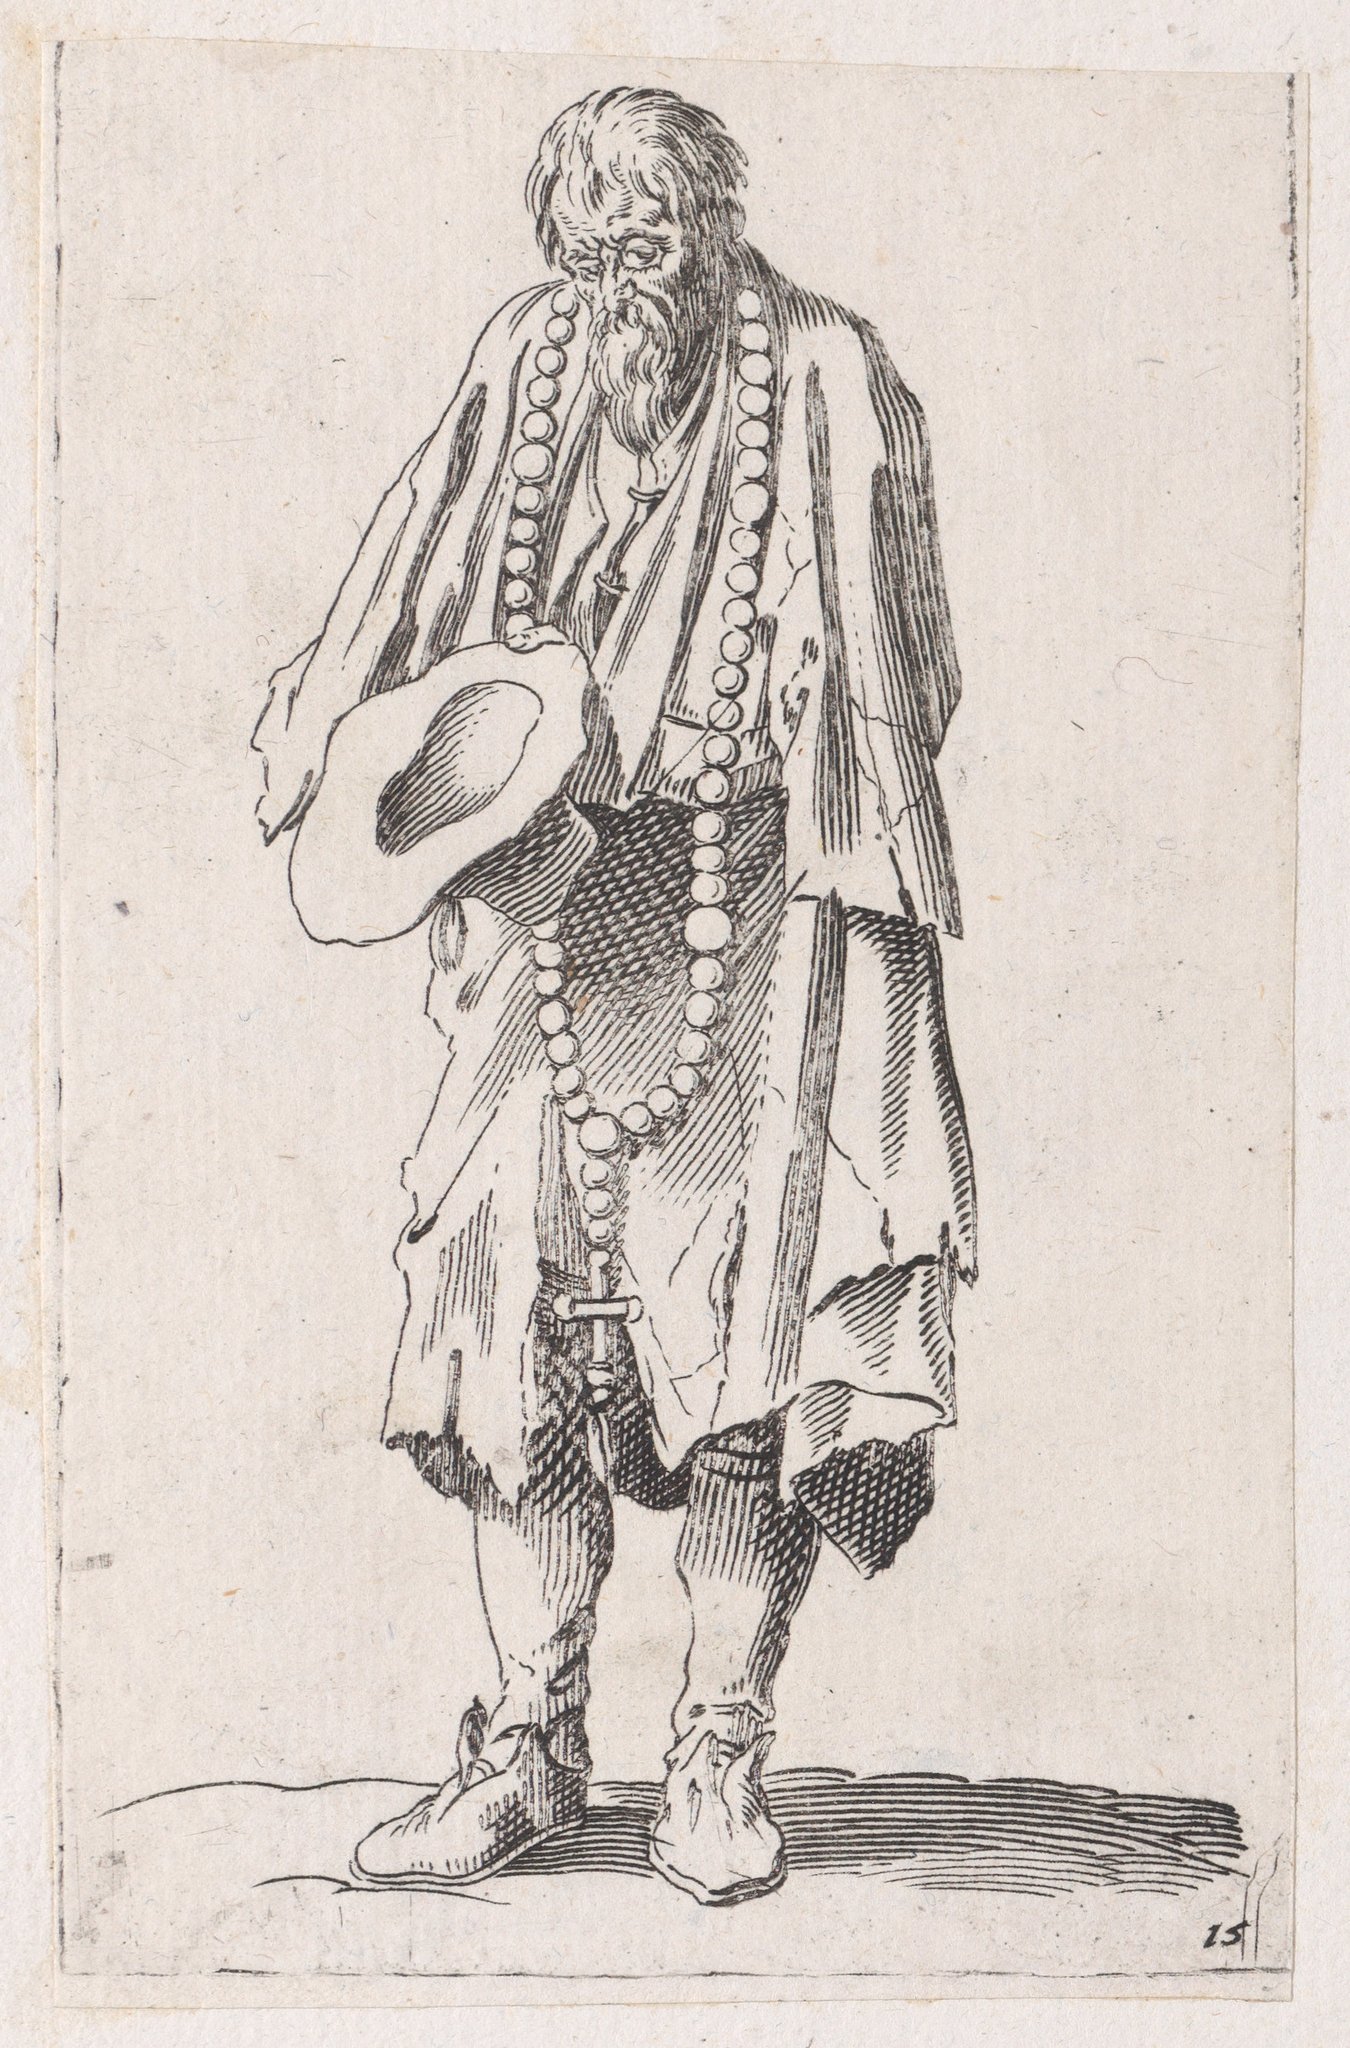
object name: print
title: Reverse Copy of Le Mendiant au Rosaire (The Beggar with a Rosary), from Les Gueux suite appelée aussi Les Mendiants, Les Baroni, ou Les Barons (The Beggars, also called the Barons)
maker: Anonymous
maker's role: artist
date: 1601-1700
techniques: etching